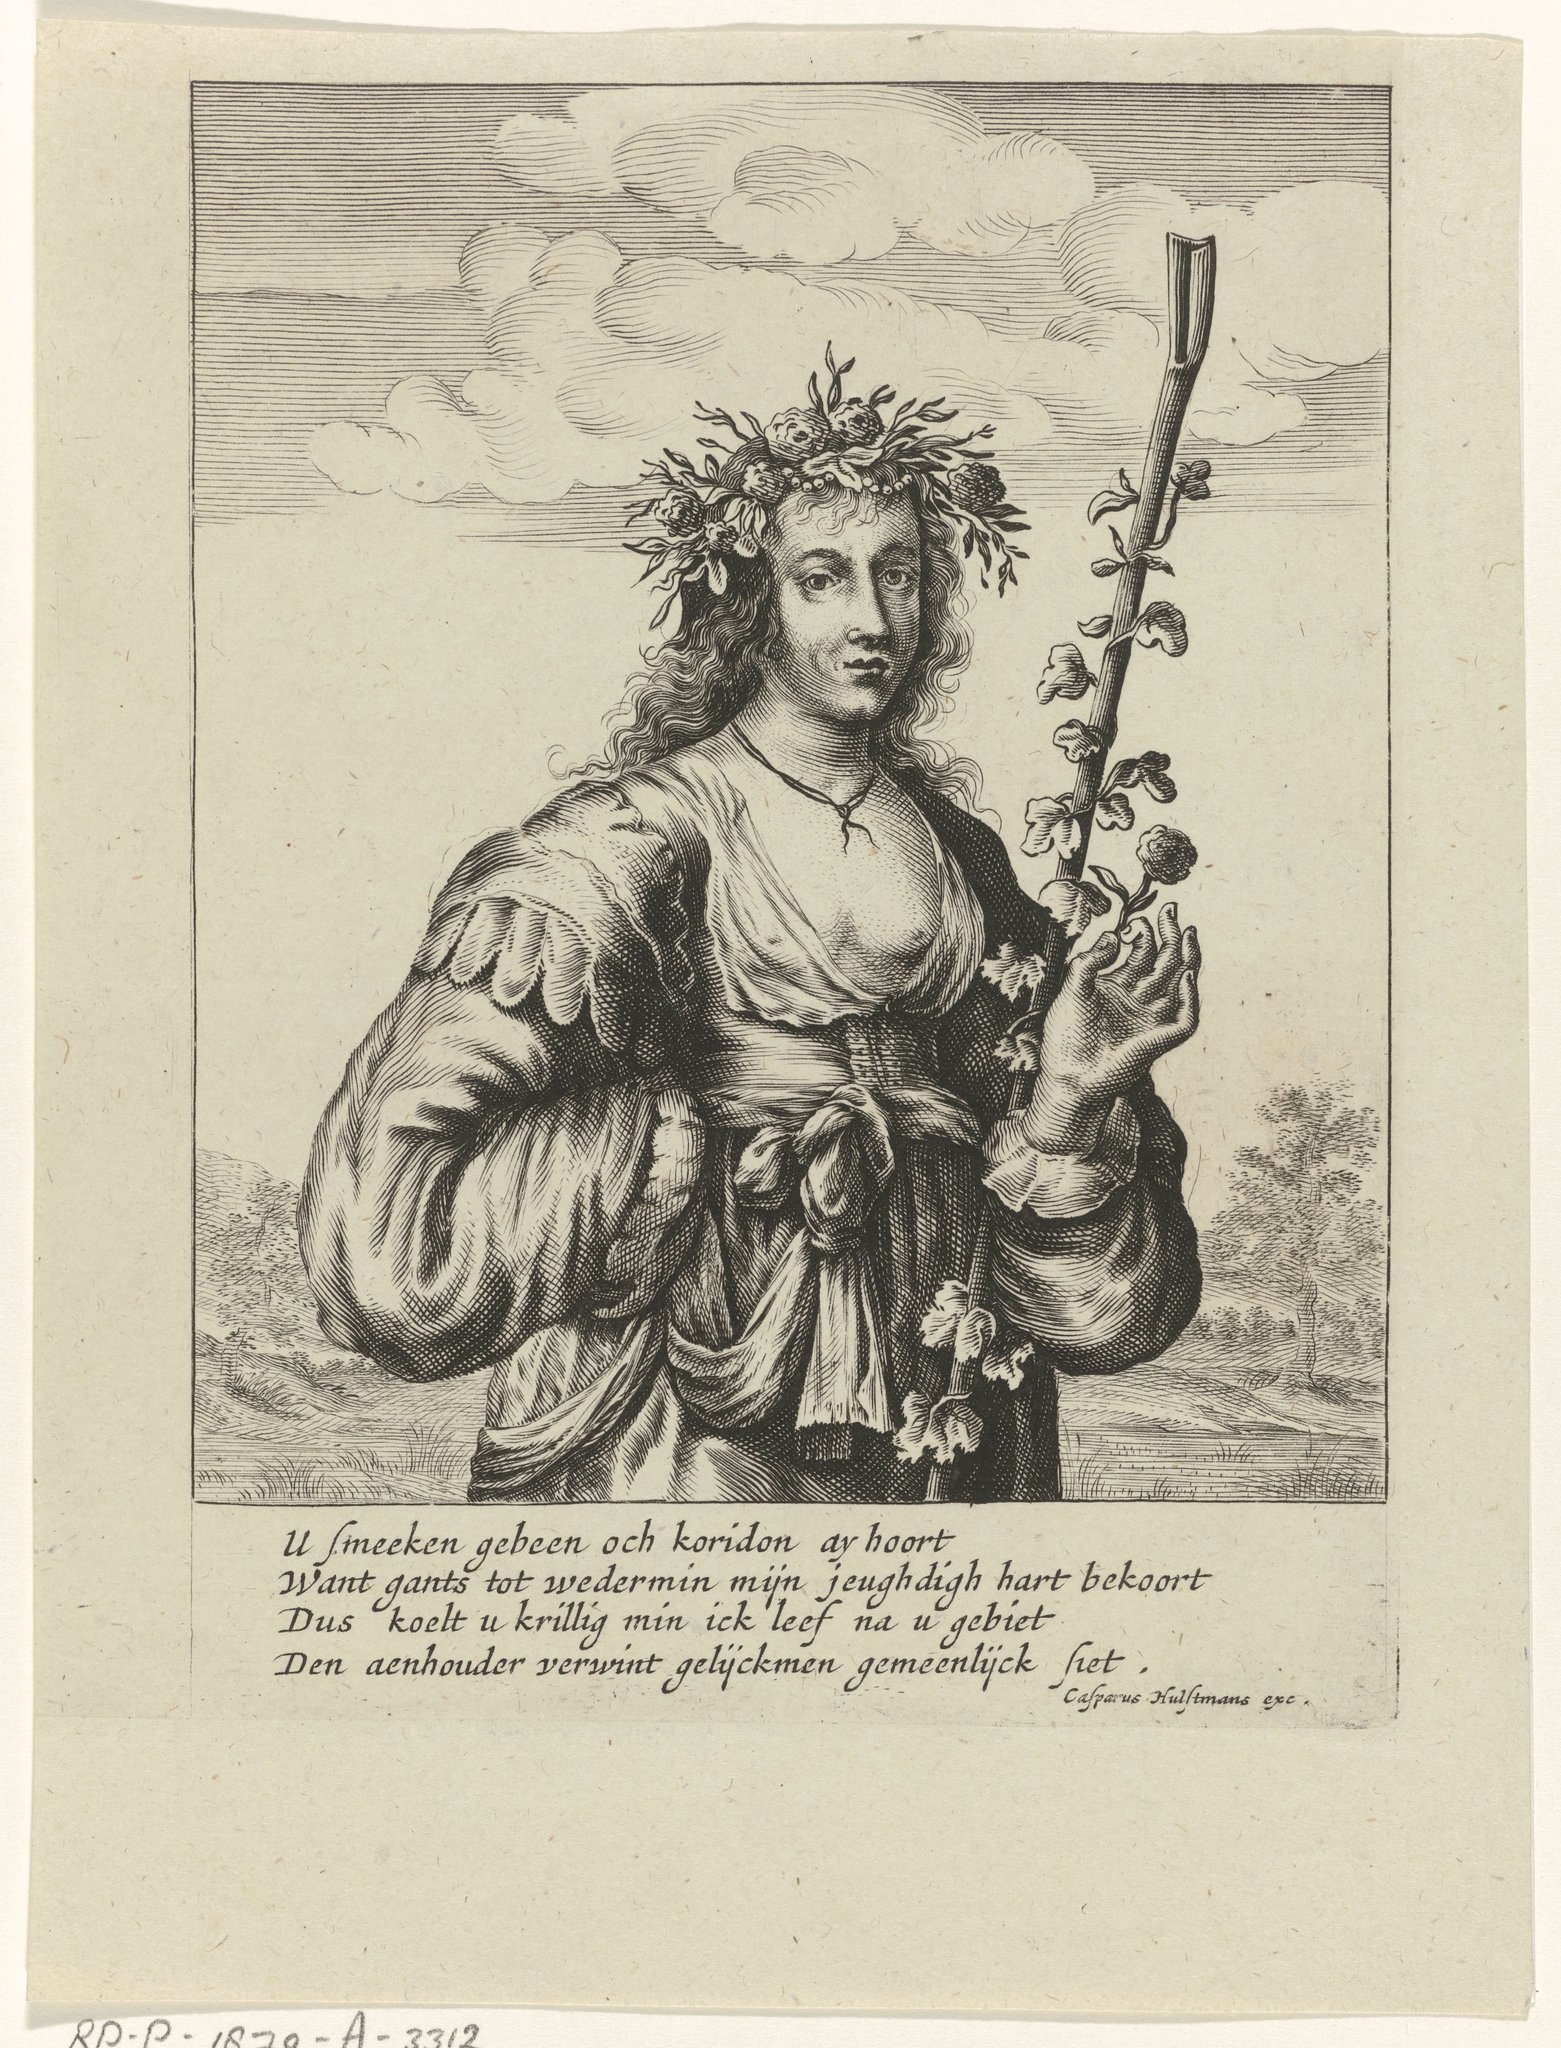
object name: print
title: Herderin Sylvia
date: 1600-1700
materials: paper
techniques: engraving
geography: netherlands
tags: herding, herdsman, herdswoman, shepherd, shepherdess, cowherd, etc., pastorals, arcadian scenes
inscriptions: collector's mark: Lugt 2228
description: De herderin Sylvia met haar herderstaf en een bloem in de hand. Onder de voorstelling een vierregelig vers in het Nederlands.